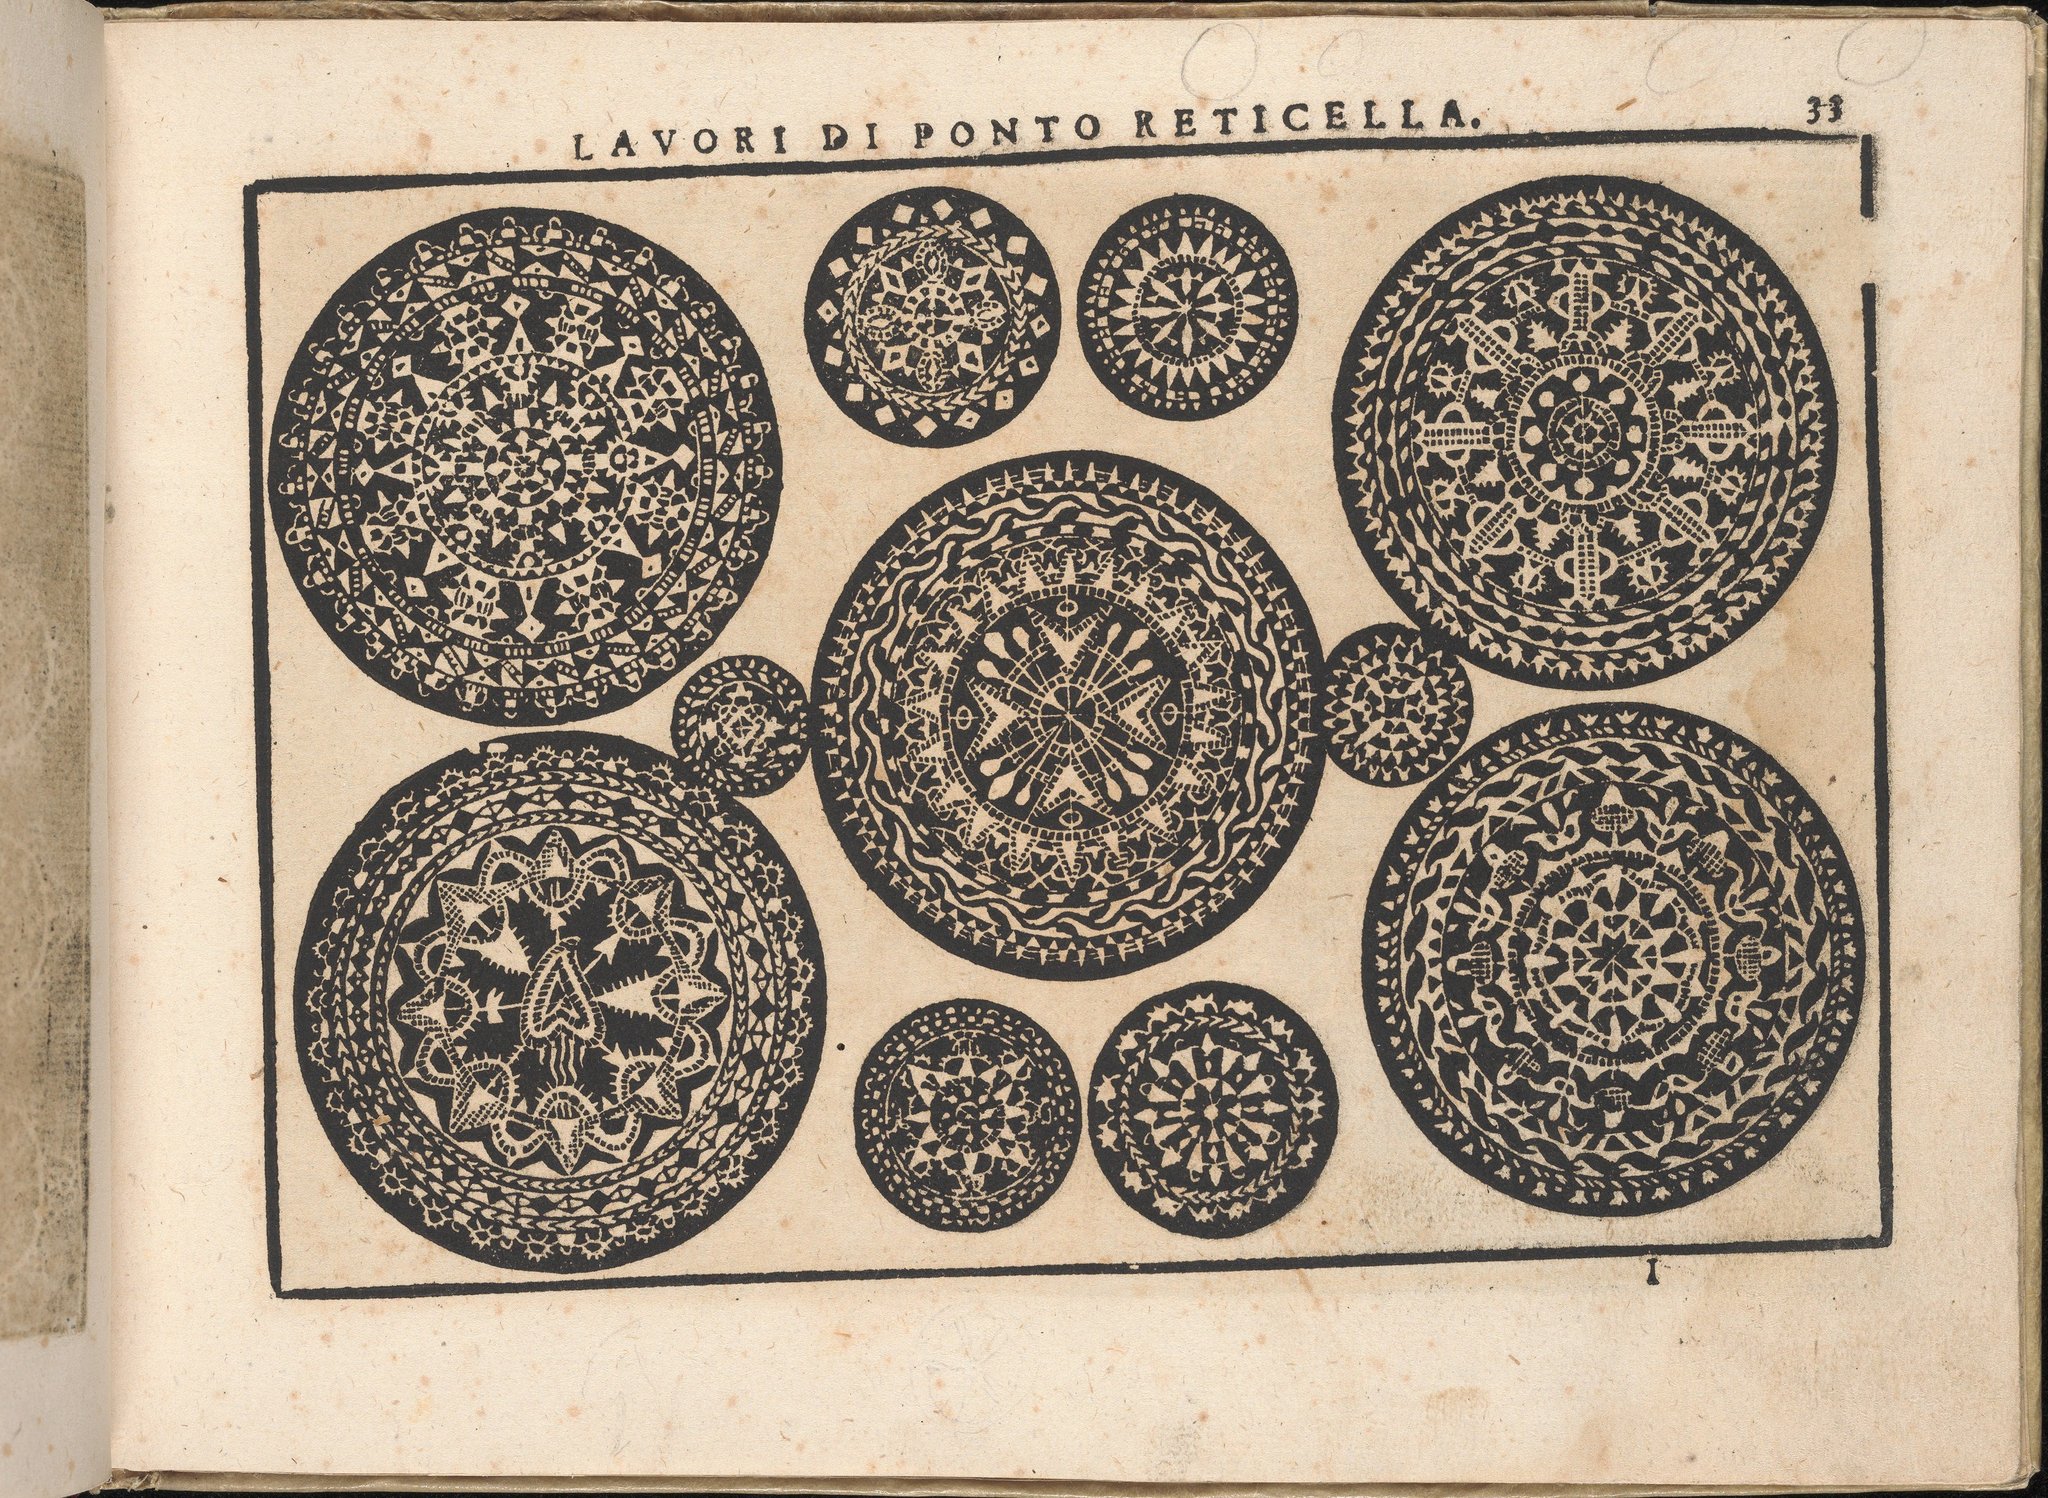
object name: book print ornament architecture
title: Fiore D'Ogni Virtu Per le Nobili Et Honeste Matrone, page 33 (recto)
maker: isabella catanea parasole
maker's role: designer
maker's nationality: italian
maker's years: 1565-1625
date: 1610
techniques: woodcut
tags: ornament